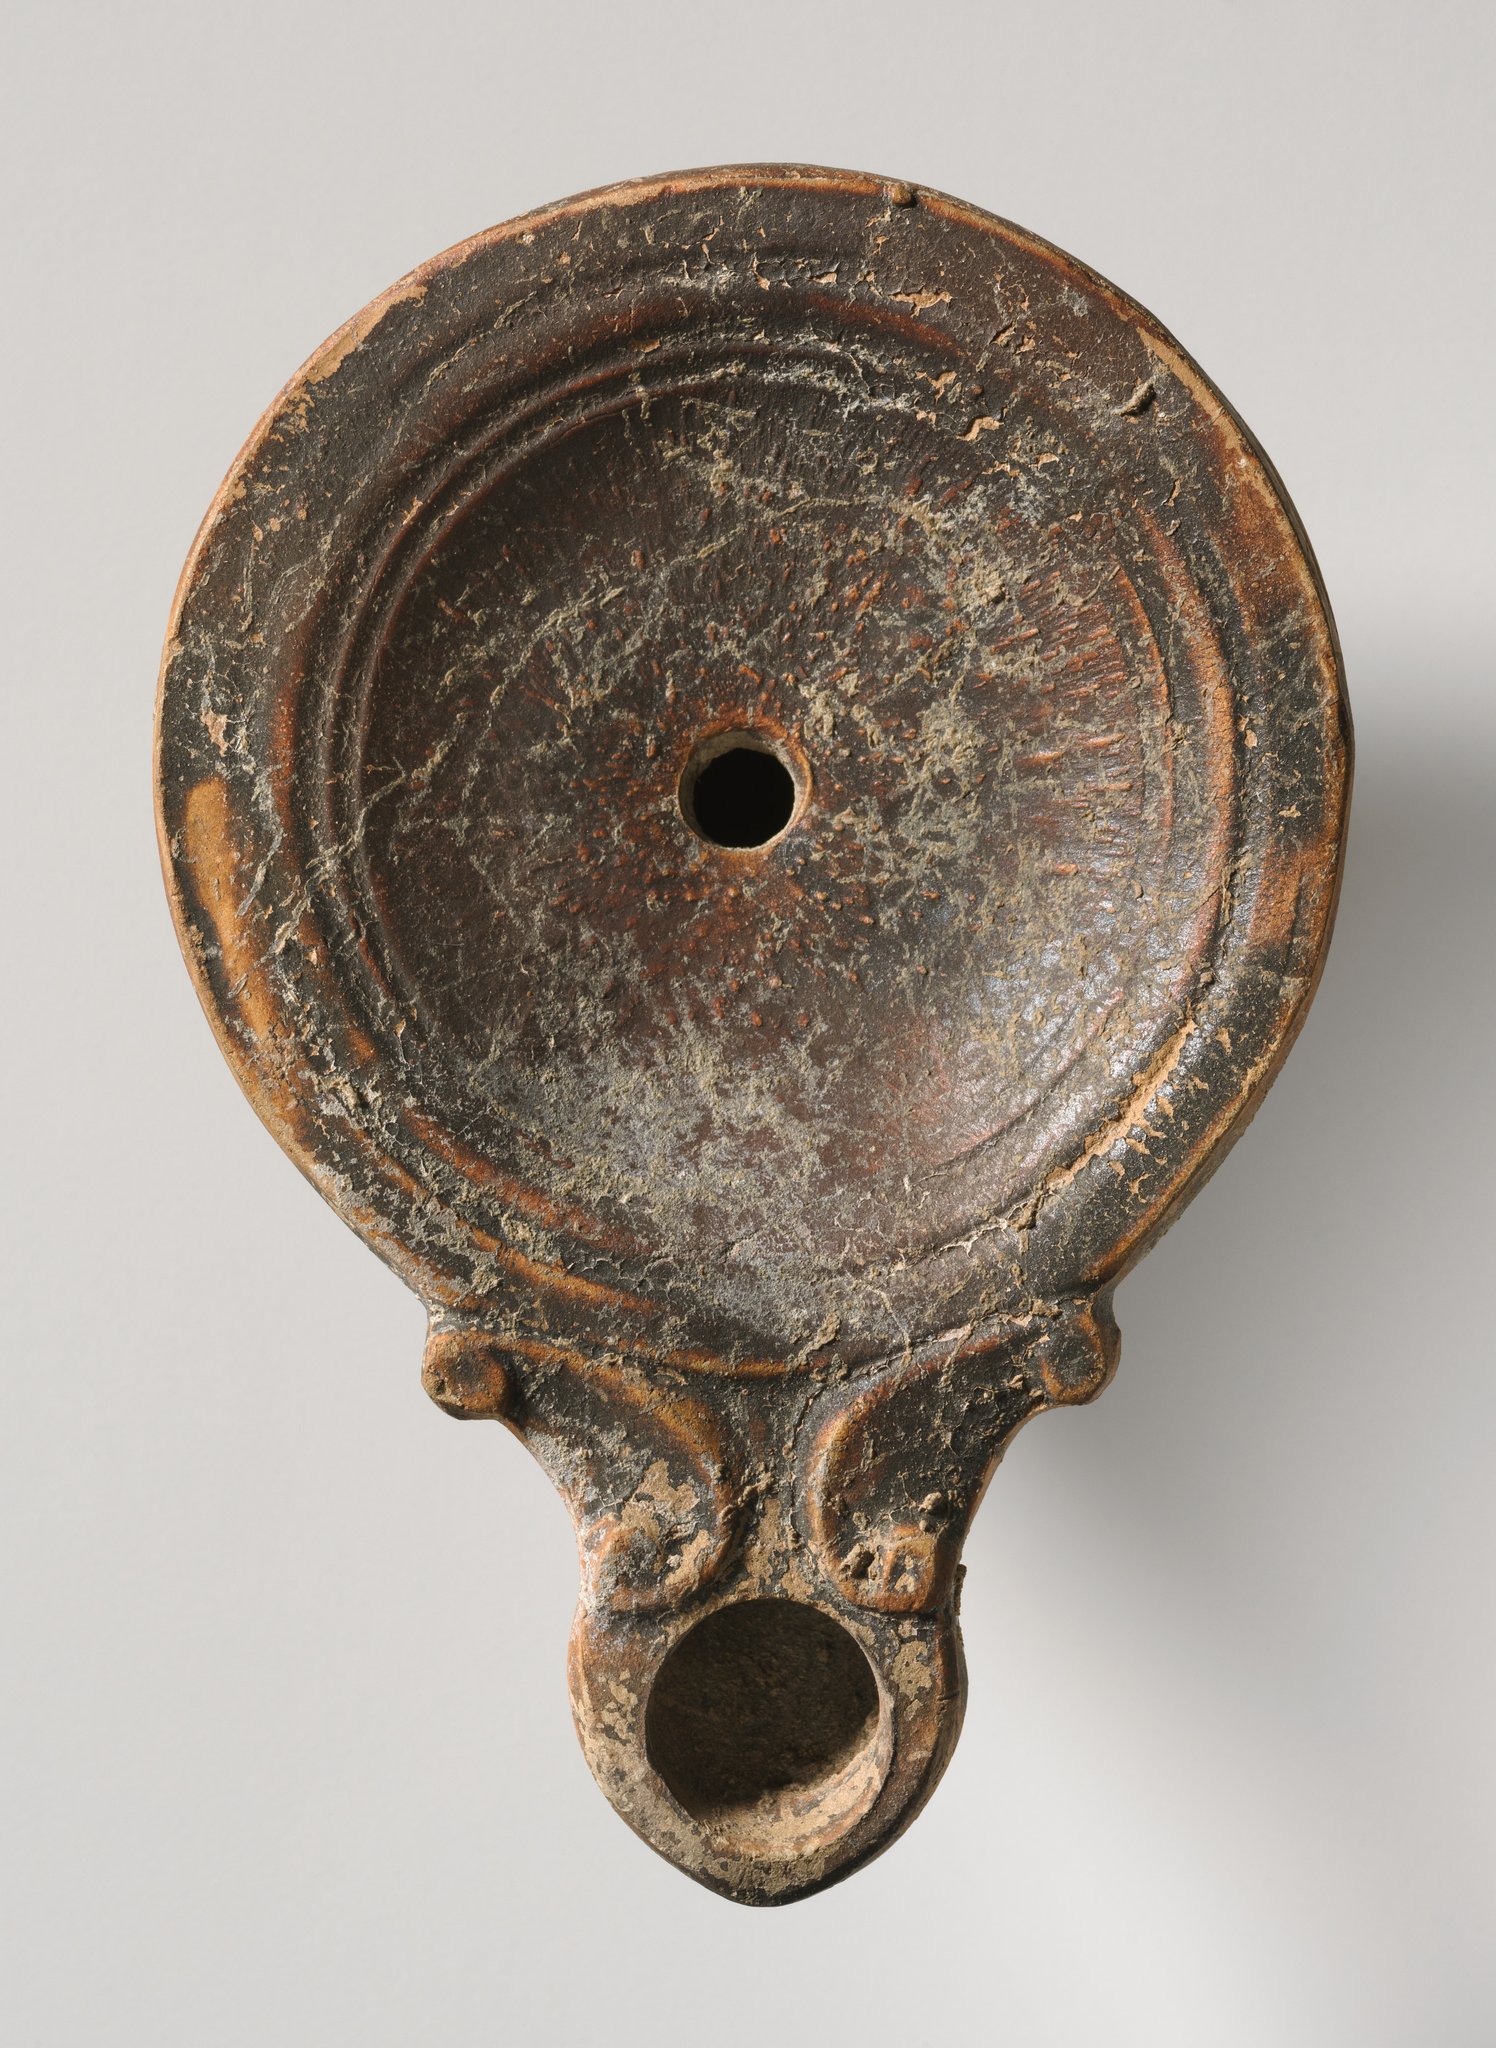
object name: lamp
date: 100 BCE-100 CE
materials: earthenware